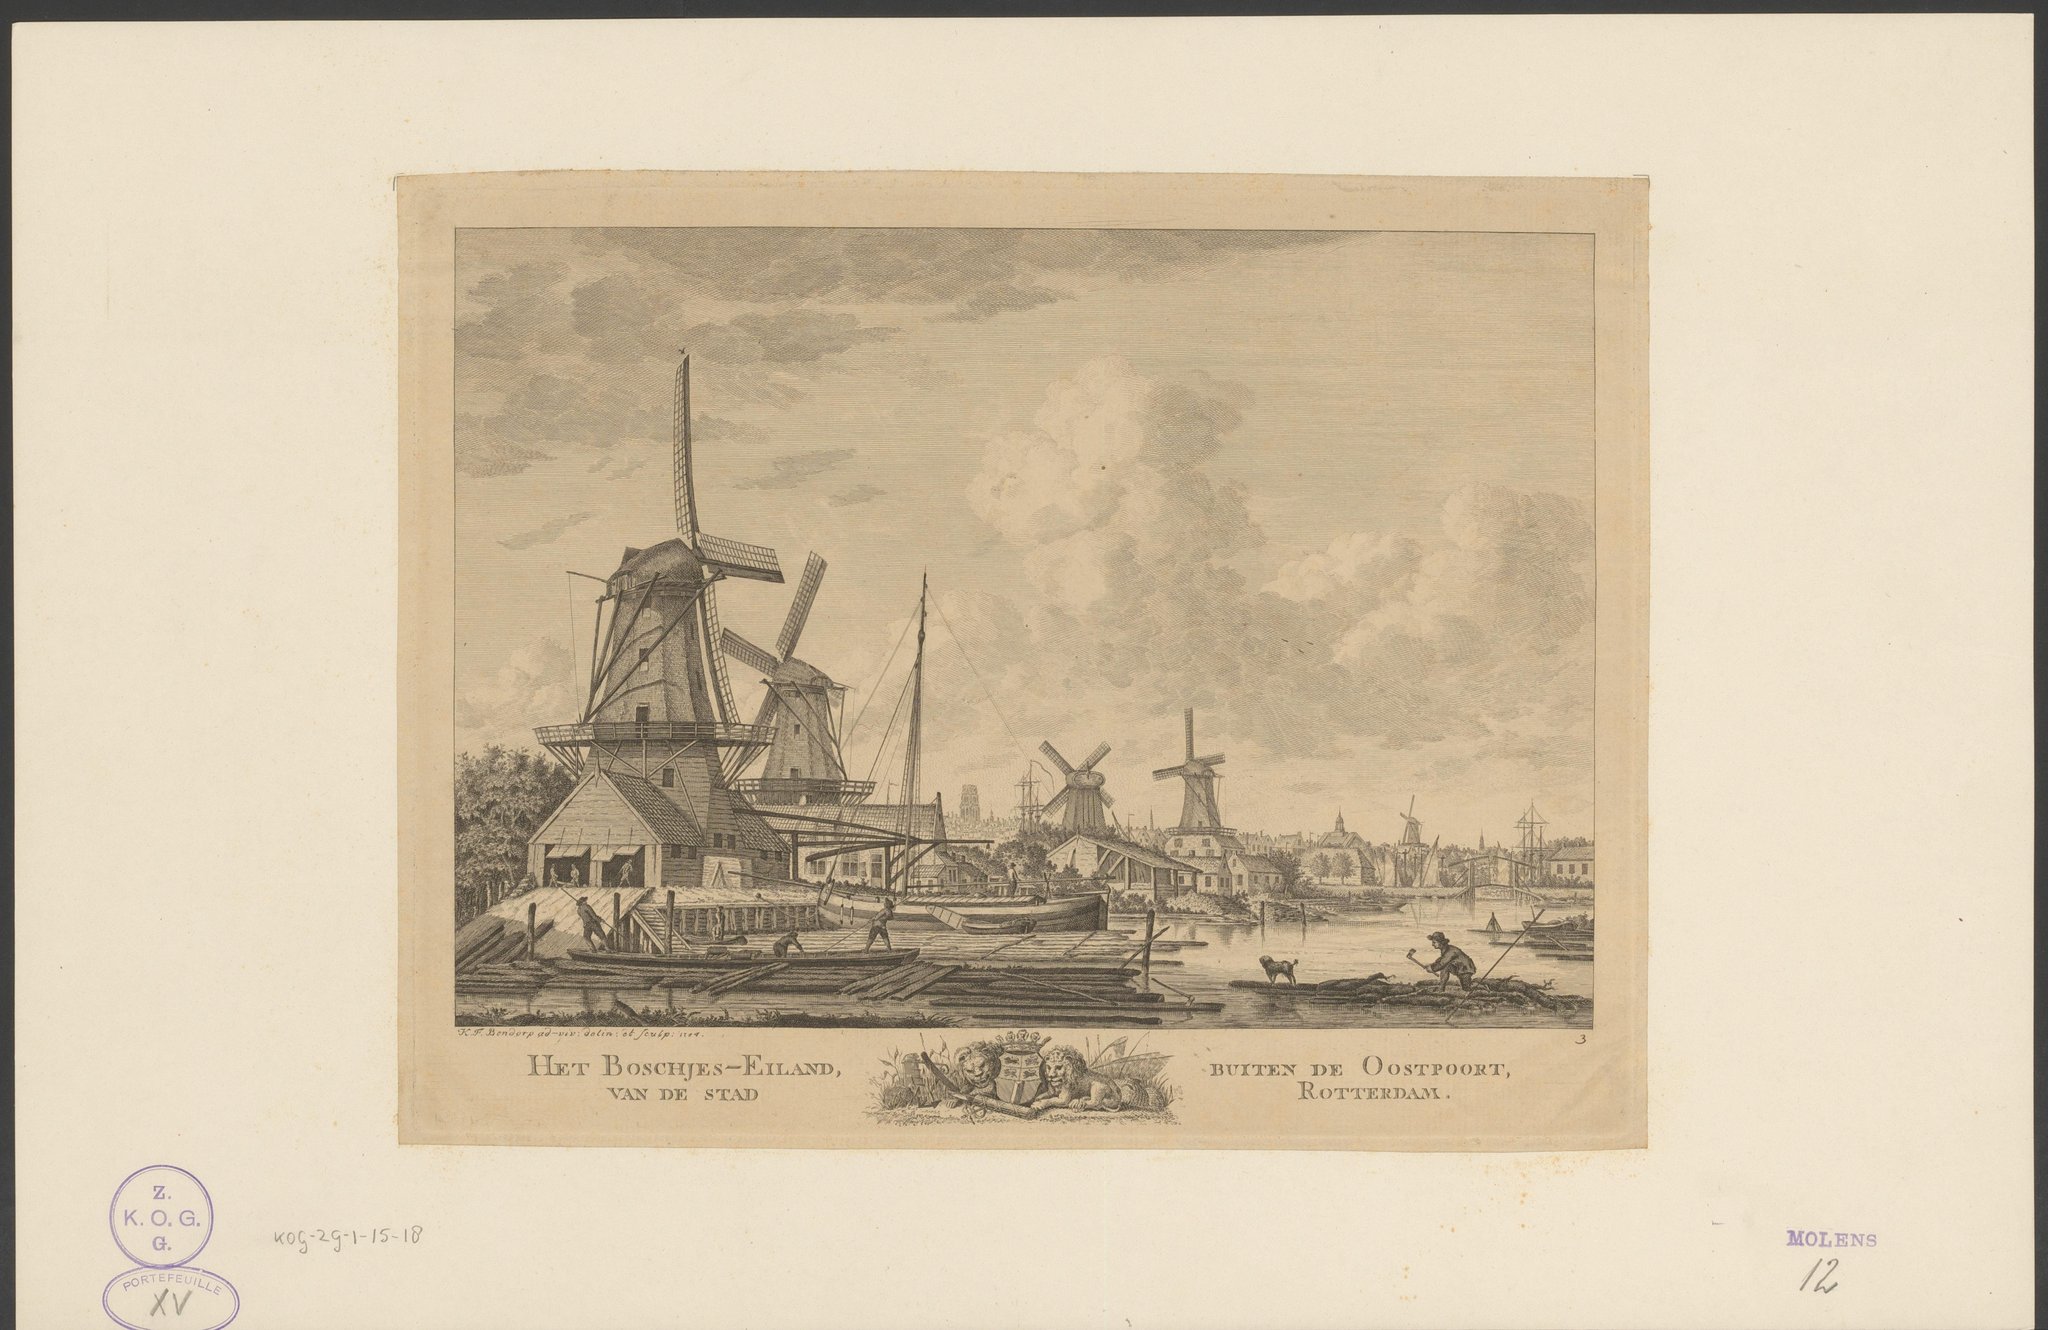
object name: print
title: Het Boschjes-Eiland, buiten de Oostpoort, van de stad Rotterdam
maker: carel frederik bendorp (ii)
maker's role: draughtsman, painter, print maker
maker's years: 1819-1897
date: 1784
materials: paper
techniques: etching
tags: windmill in landscape, shipyard-workers, rotterdam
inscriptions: stamp, stamp, collector's mark: Lugt 1641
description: De prent maakt deel uit van een 100-delige serie met gezichten op dorpen en steden te Kleef. Prent mogelijk uit: Beijer, Jan de. Het verheerlykt Kleefschland of Kabinet van Kleefsche oudheden en gezigten. Amsterdam: Jan de Groot [etc.], 1792.